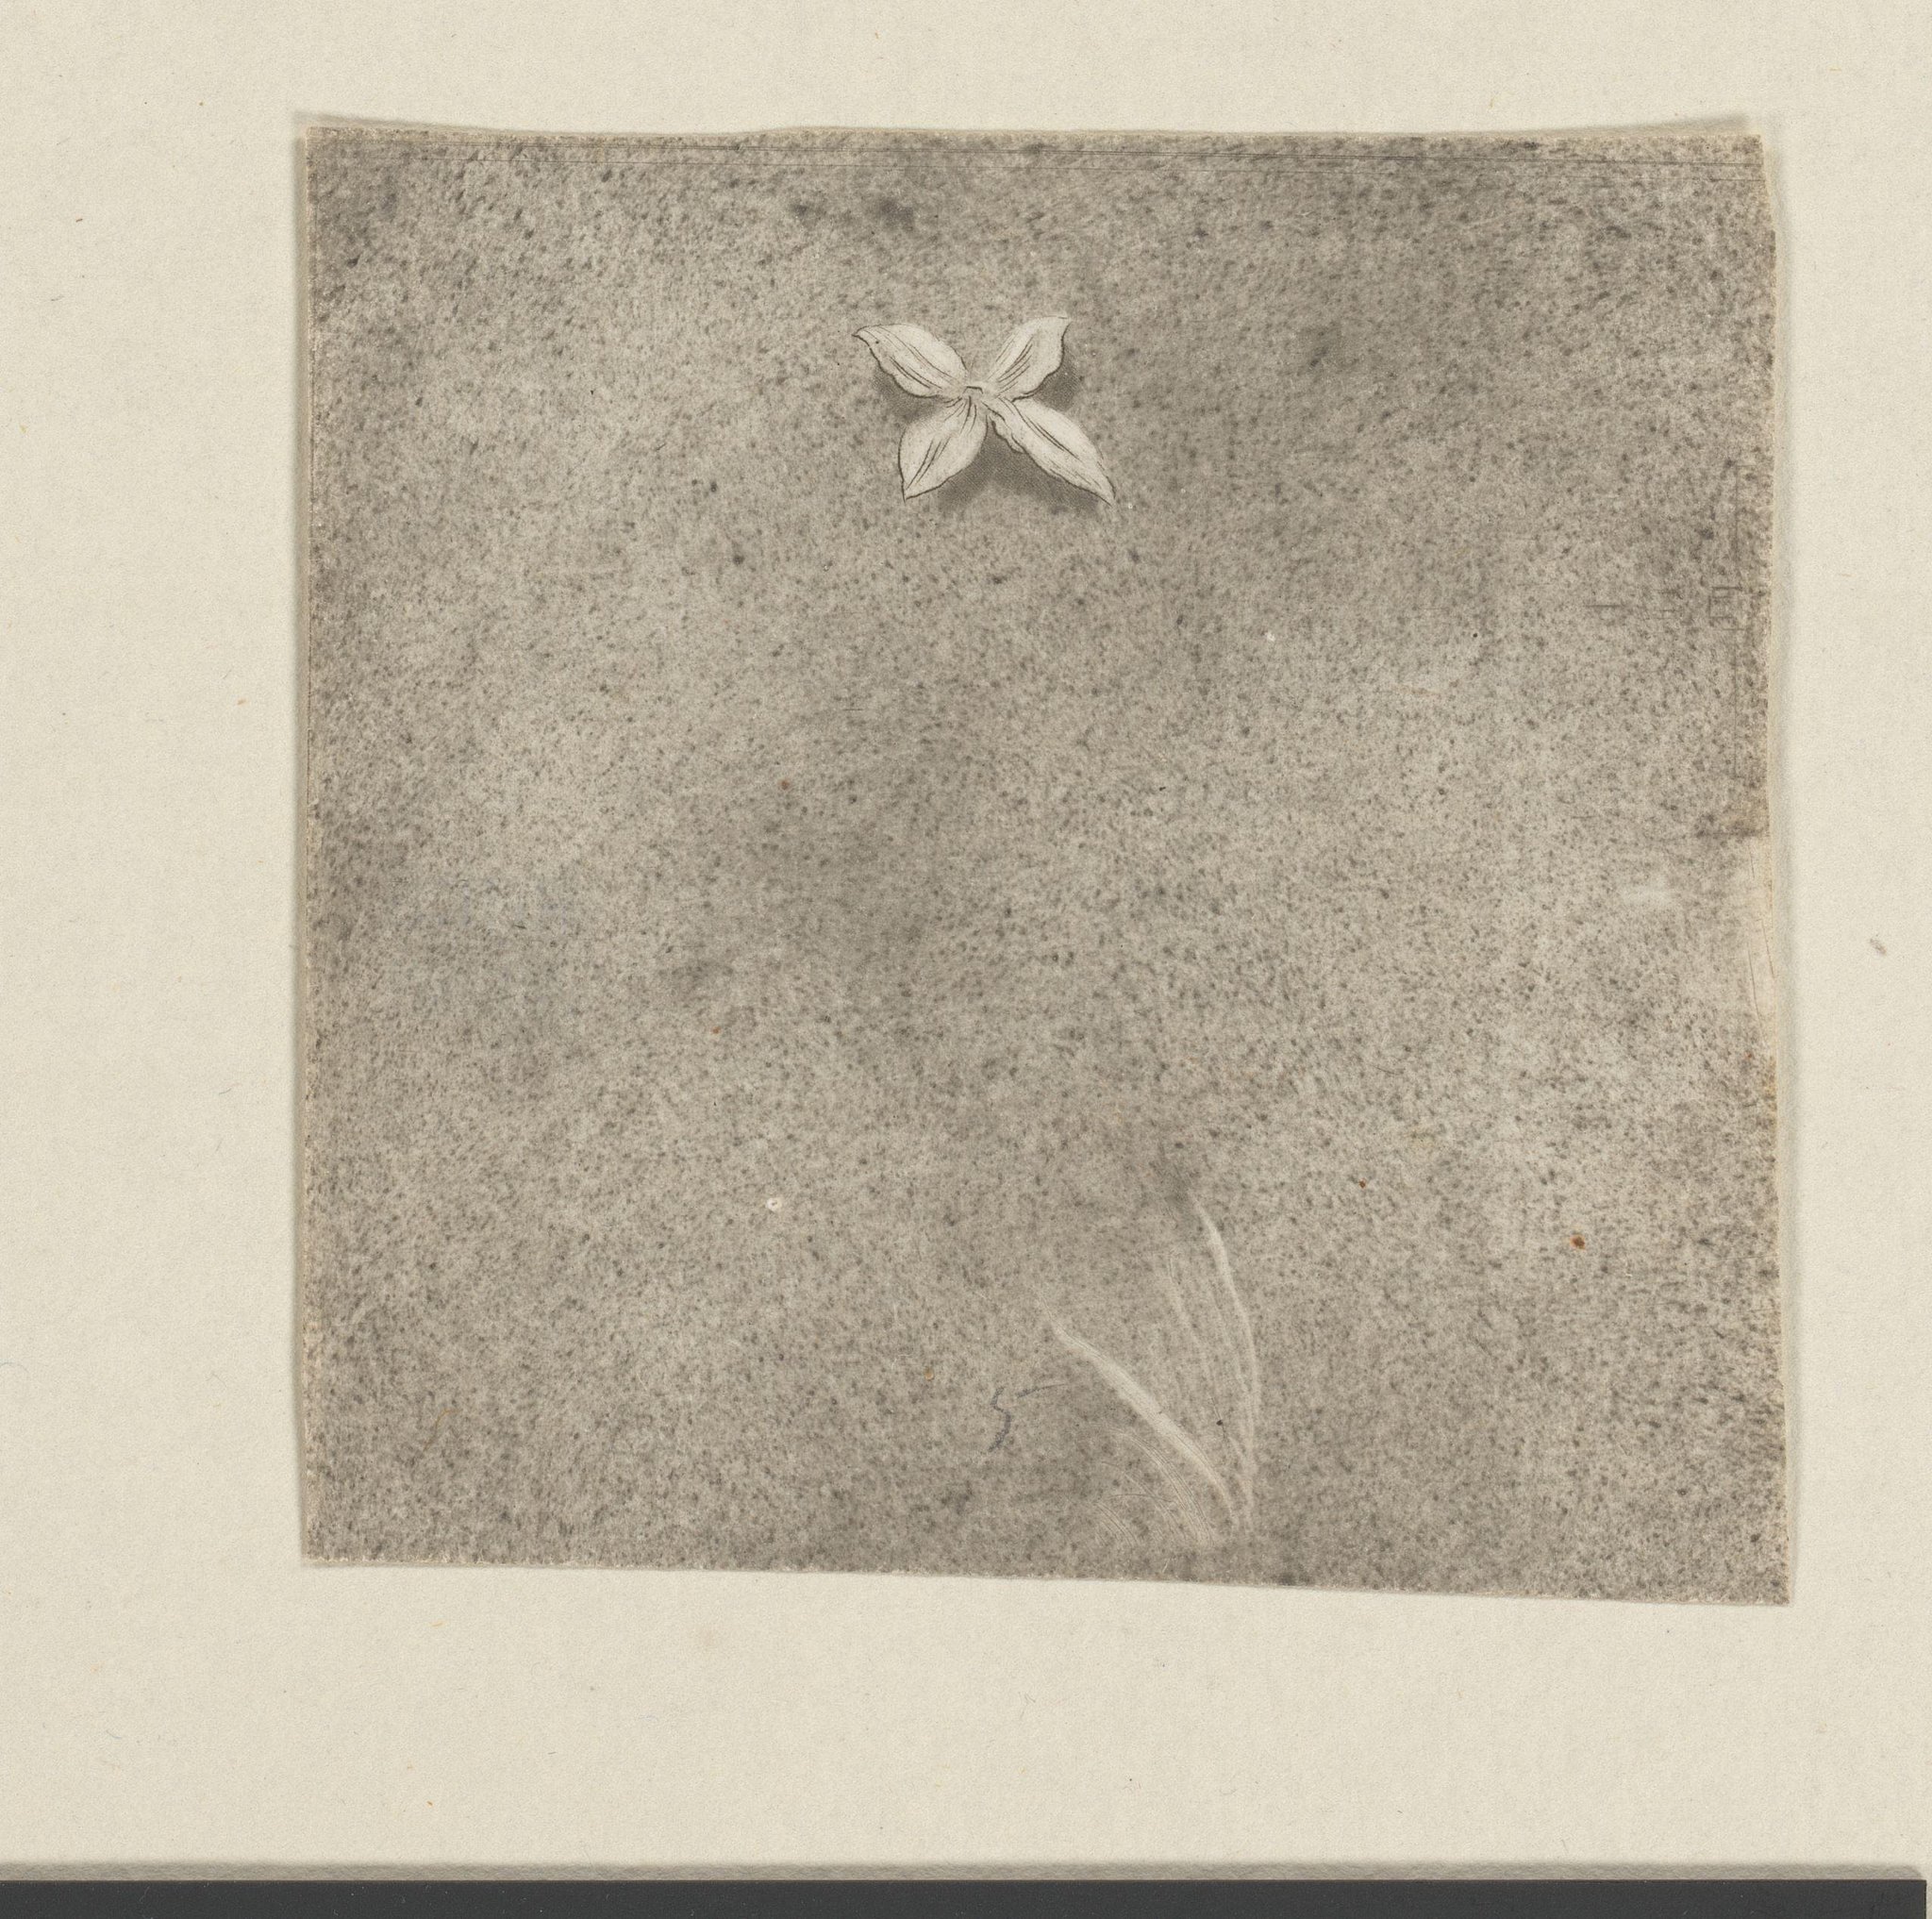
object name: print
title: Proef met bloem op grijze achtergrond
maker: cornelis ploos van amstel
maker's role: draughtsman, print maker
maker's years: 1726-1798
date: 1736-1798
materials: paper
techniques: etching, roulette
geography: amsterdam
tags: flowers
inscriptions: inscription: ‘Keuls aard van Spa waterkannen in de Pars doorgedrukt./ in een doekjen gestoven op de schoone plaat, een papier erover en stuk loot op 't papier’, collector's mark: ‘RIJKS / MUSM’